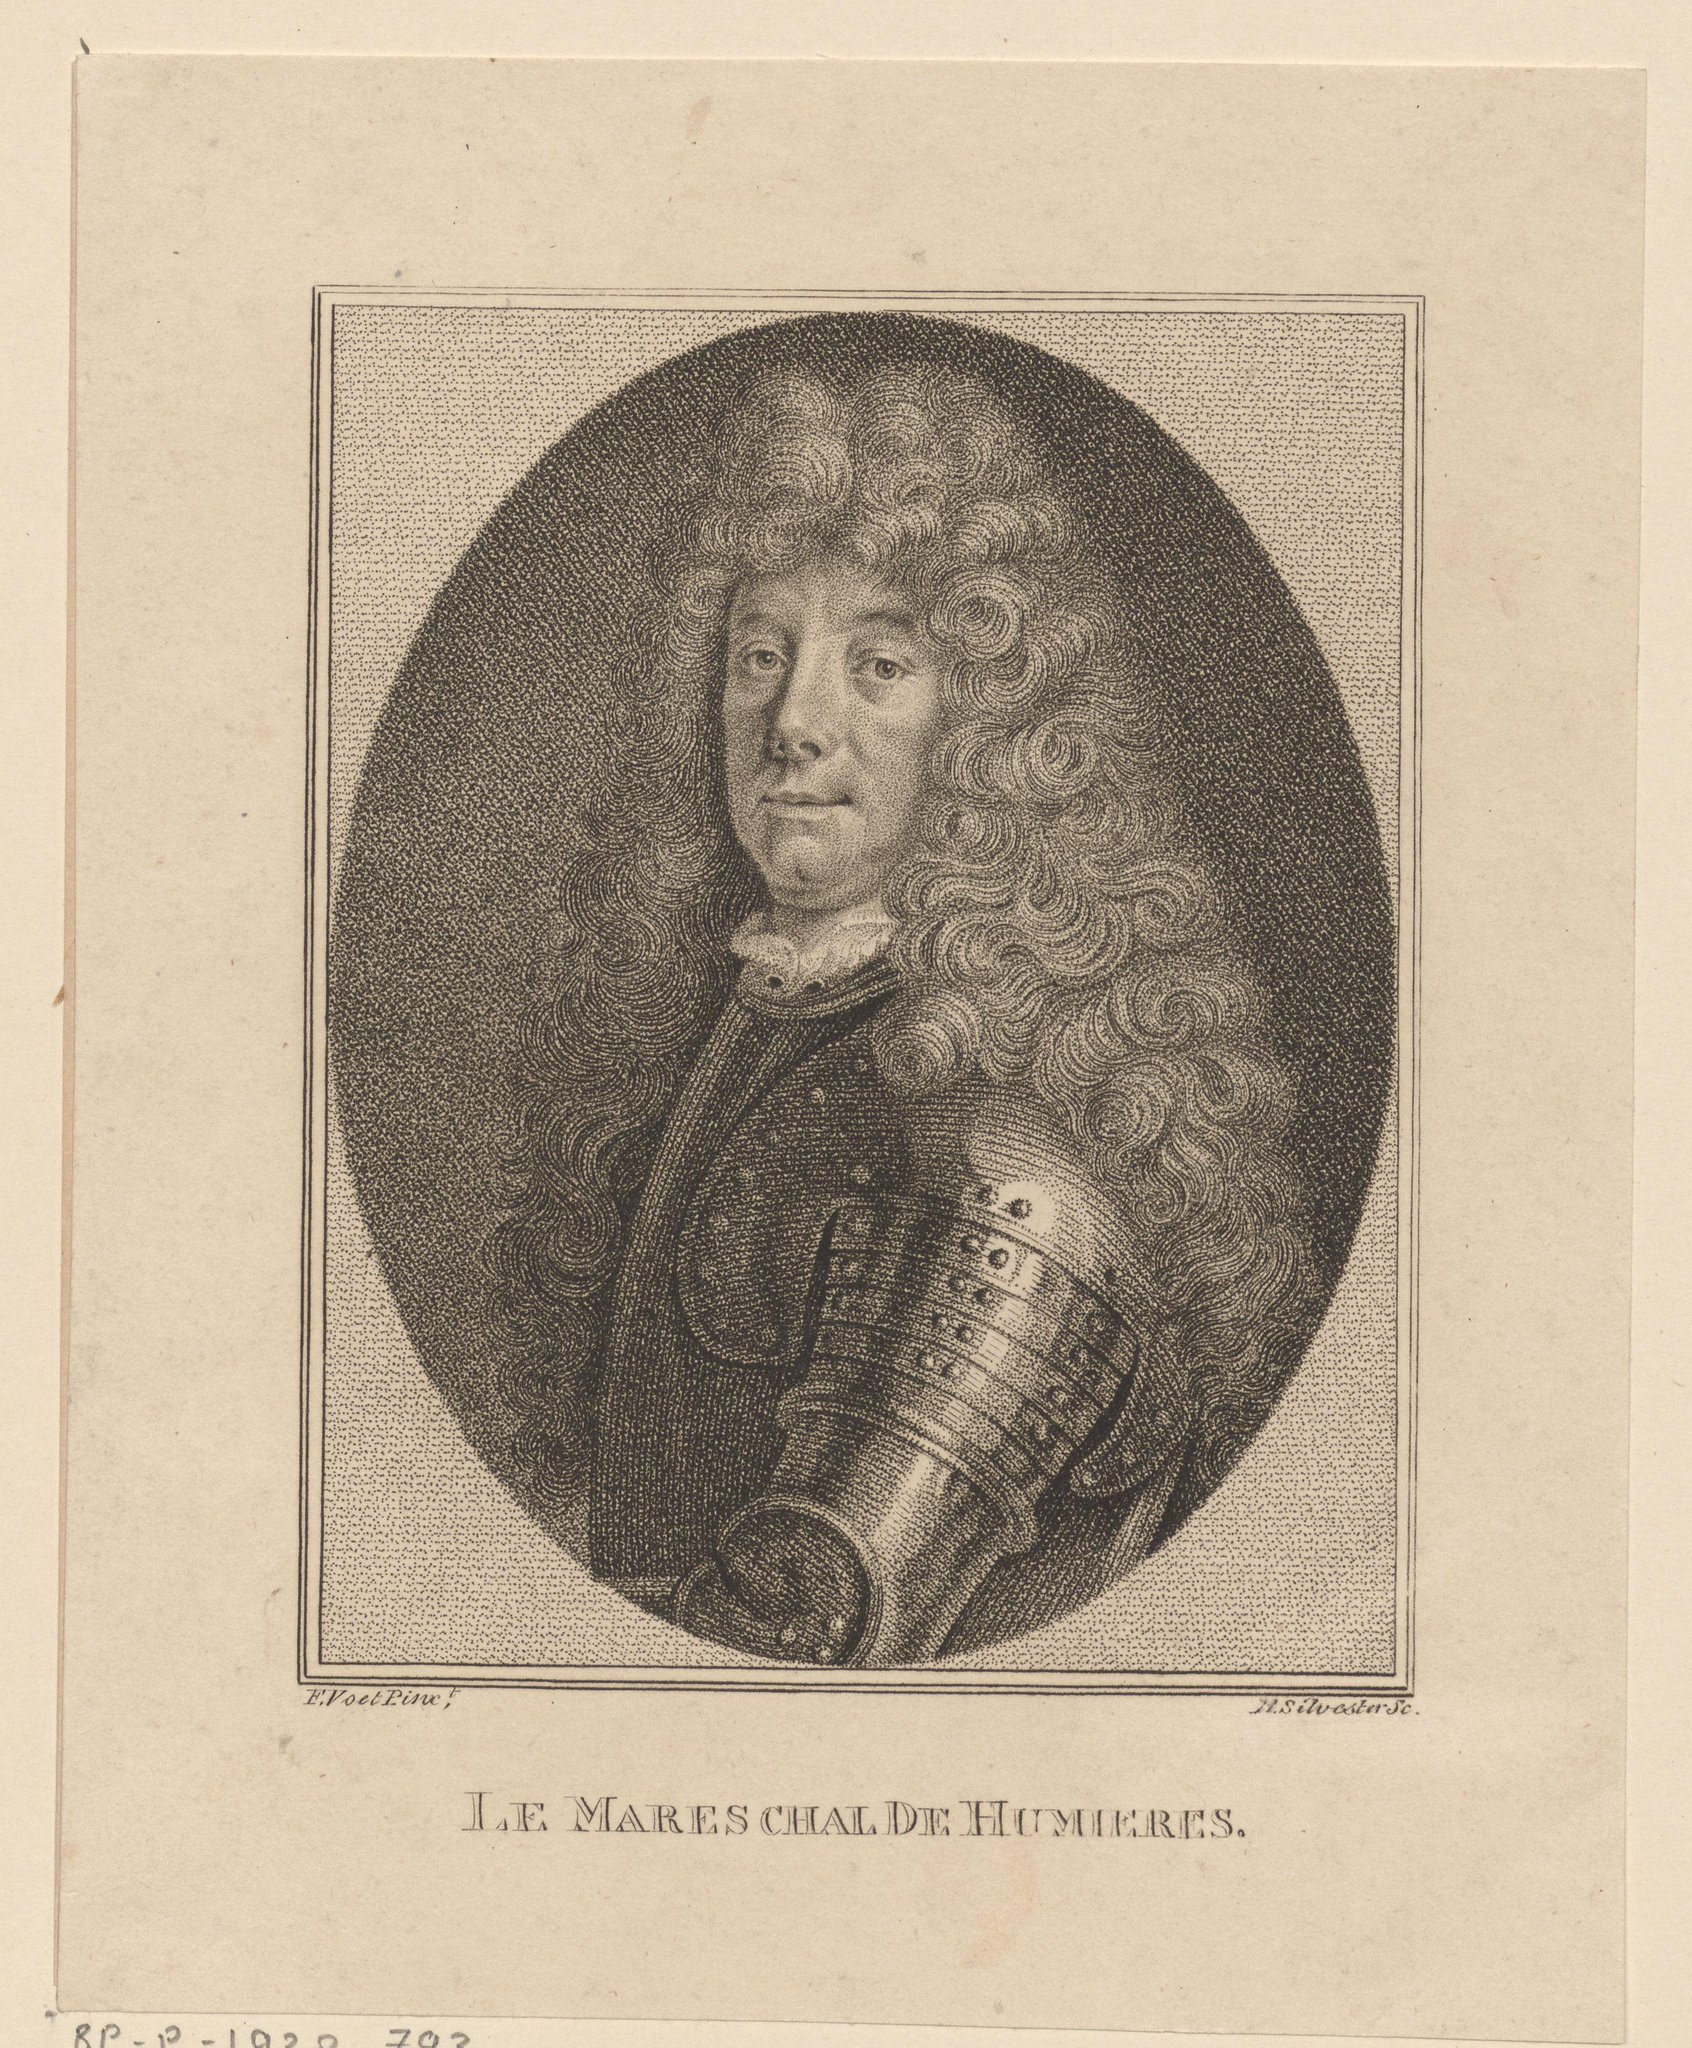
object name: print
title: Portret van Louis de Crévant, hertog van Humières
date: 1775-1824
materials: paper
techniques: etching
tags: louis de crévant (hertog van humières), armour, historical persons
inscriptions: collector's mark: Lugt 2228